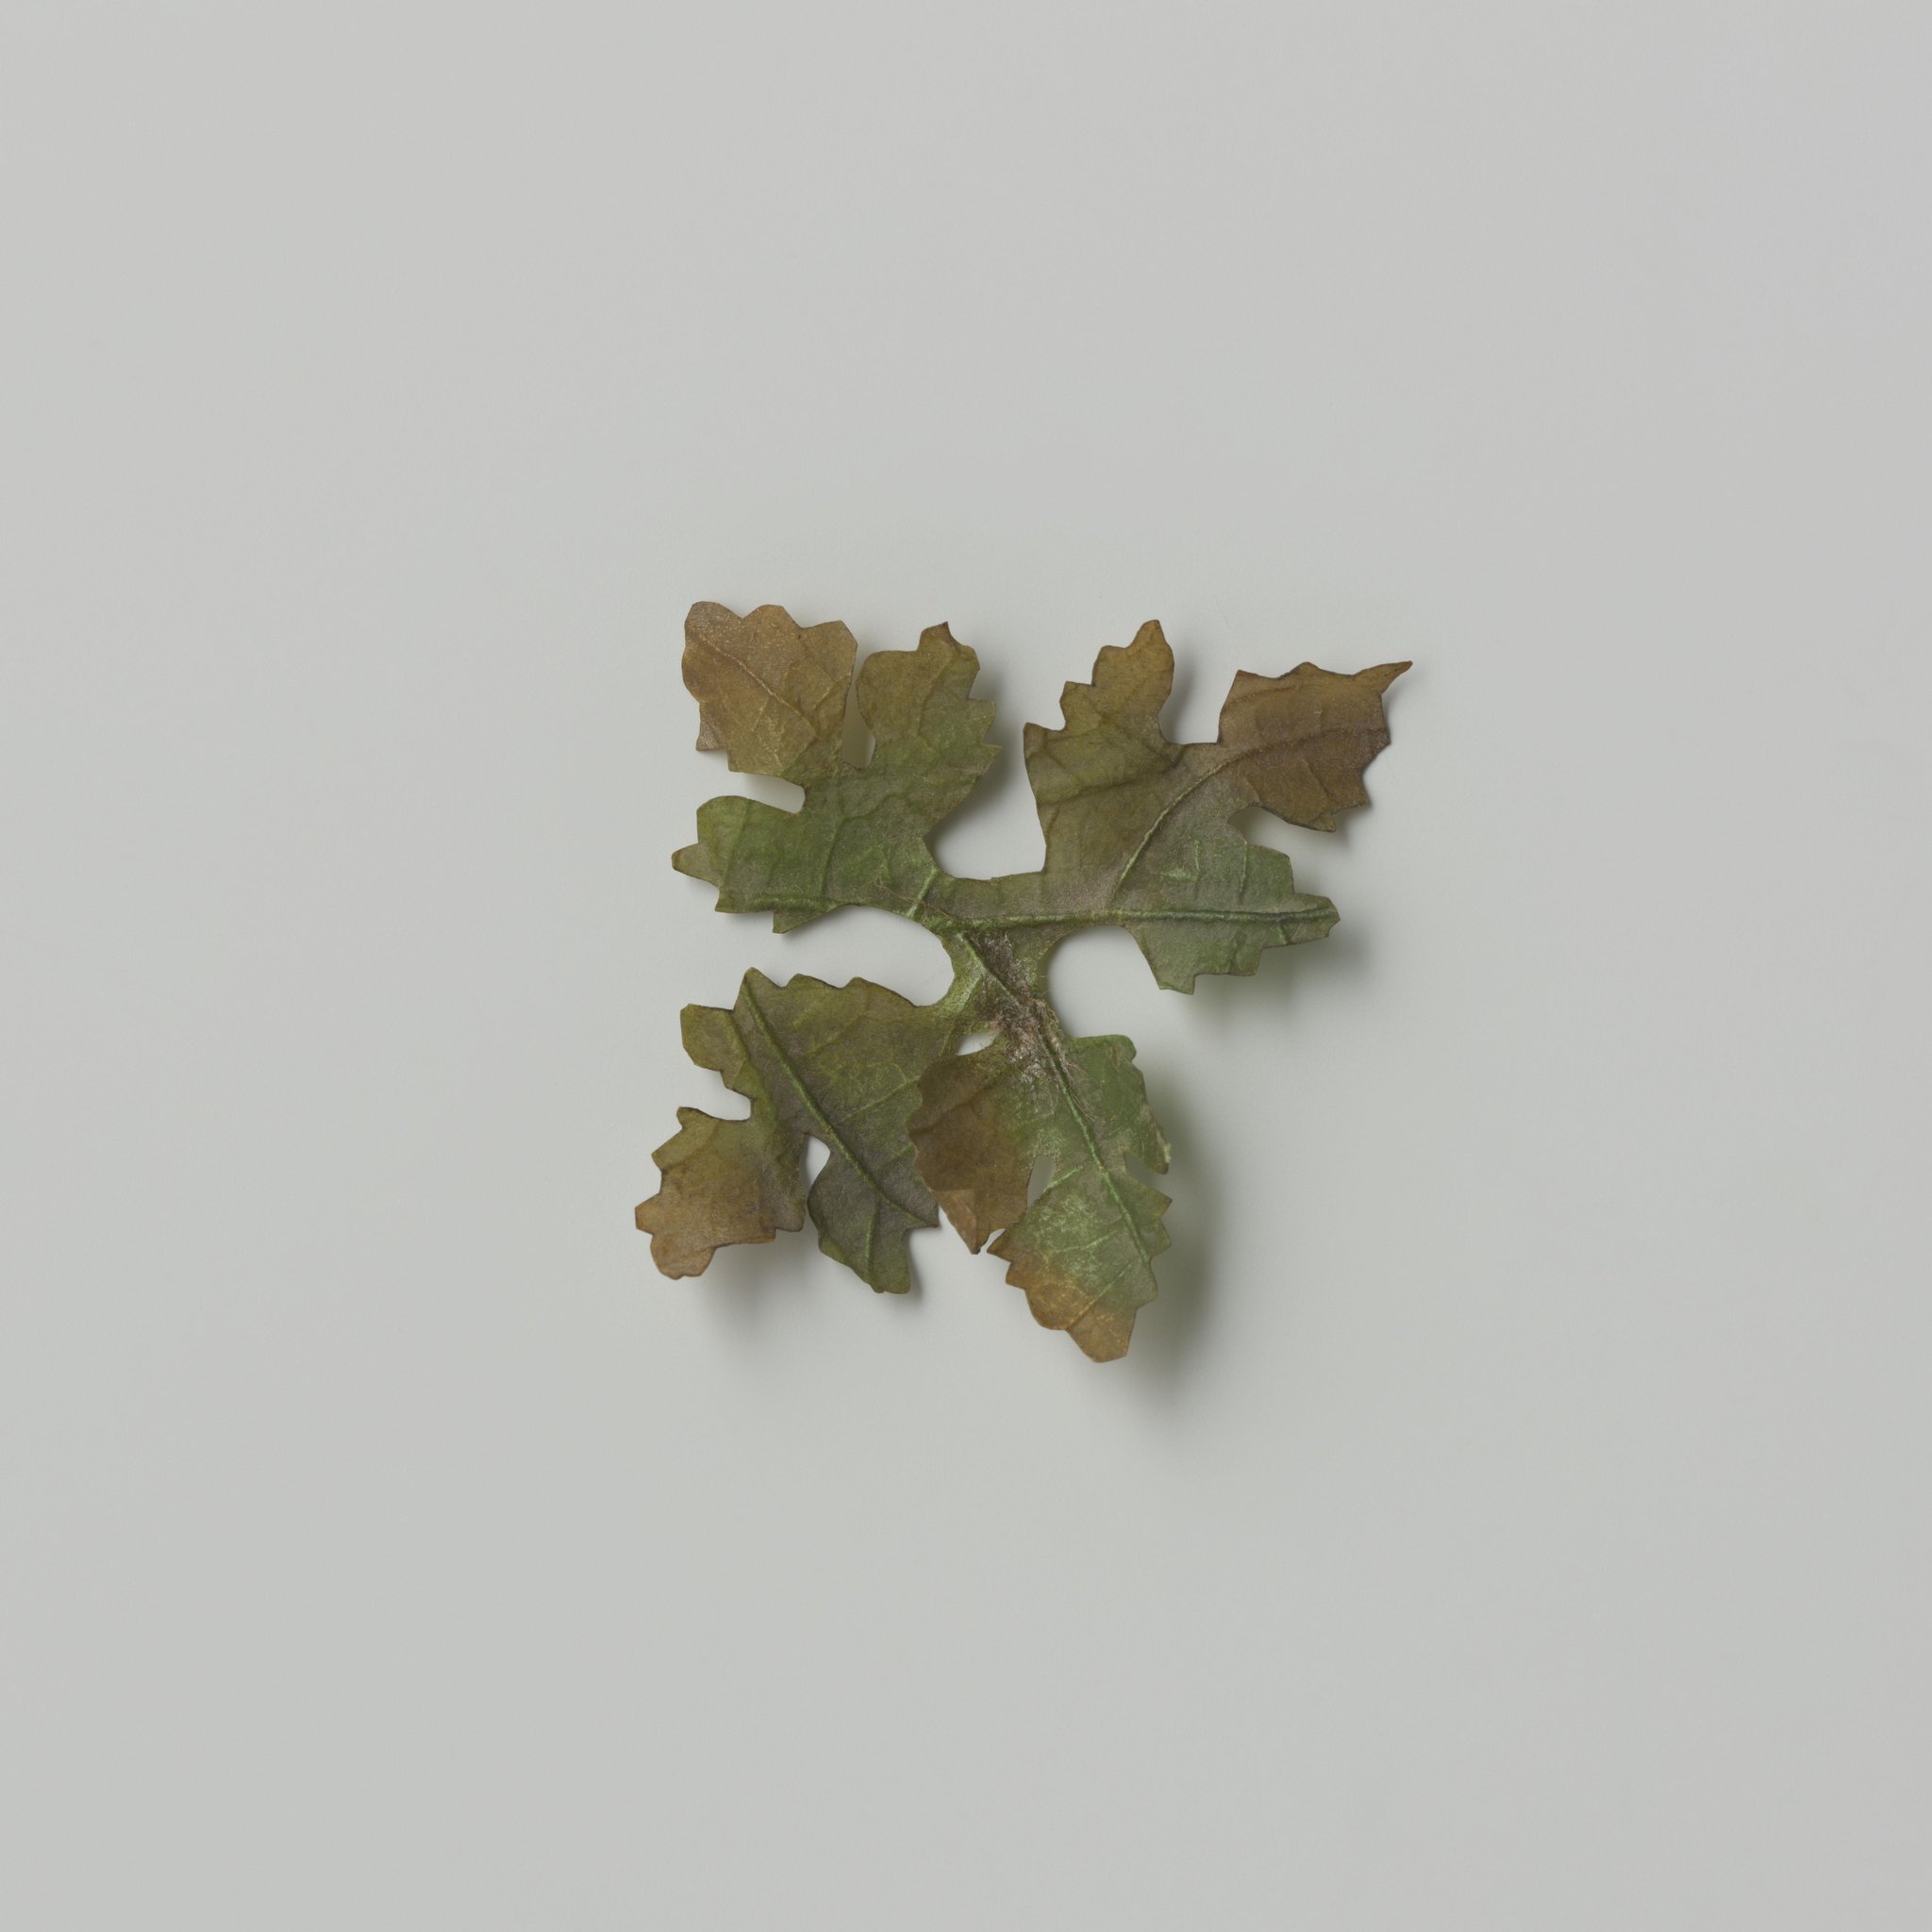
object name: druiveblad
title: Druiveblad, geknipt uit met nerven geperst en groen / bruin gekleurd perkament (?).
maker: Anonymous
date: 1700-1900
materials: parchment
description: Druiveblad, geknipt uit met nerven geperst, en groen/bruin gekleurd perkament (?)